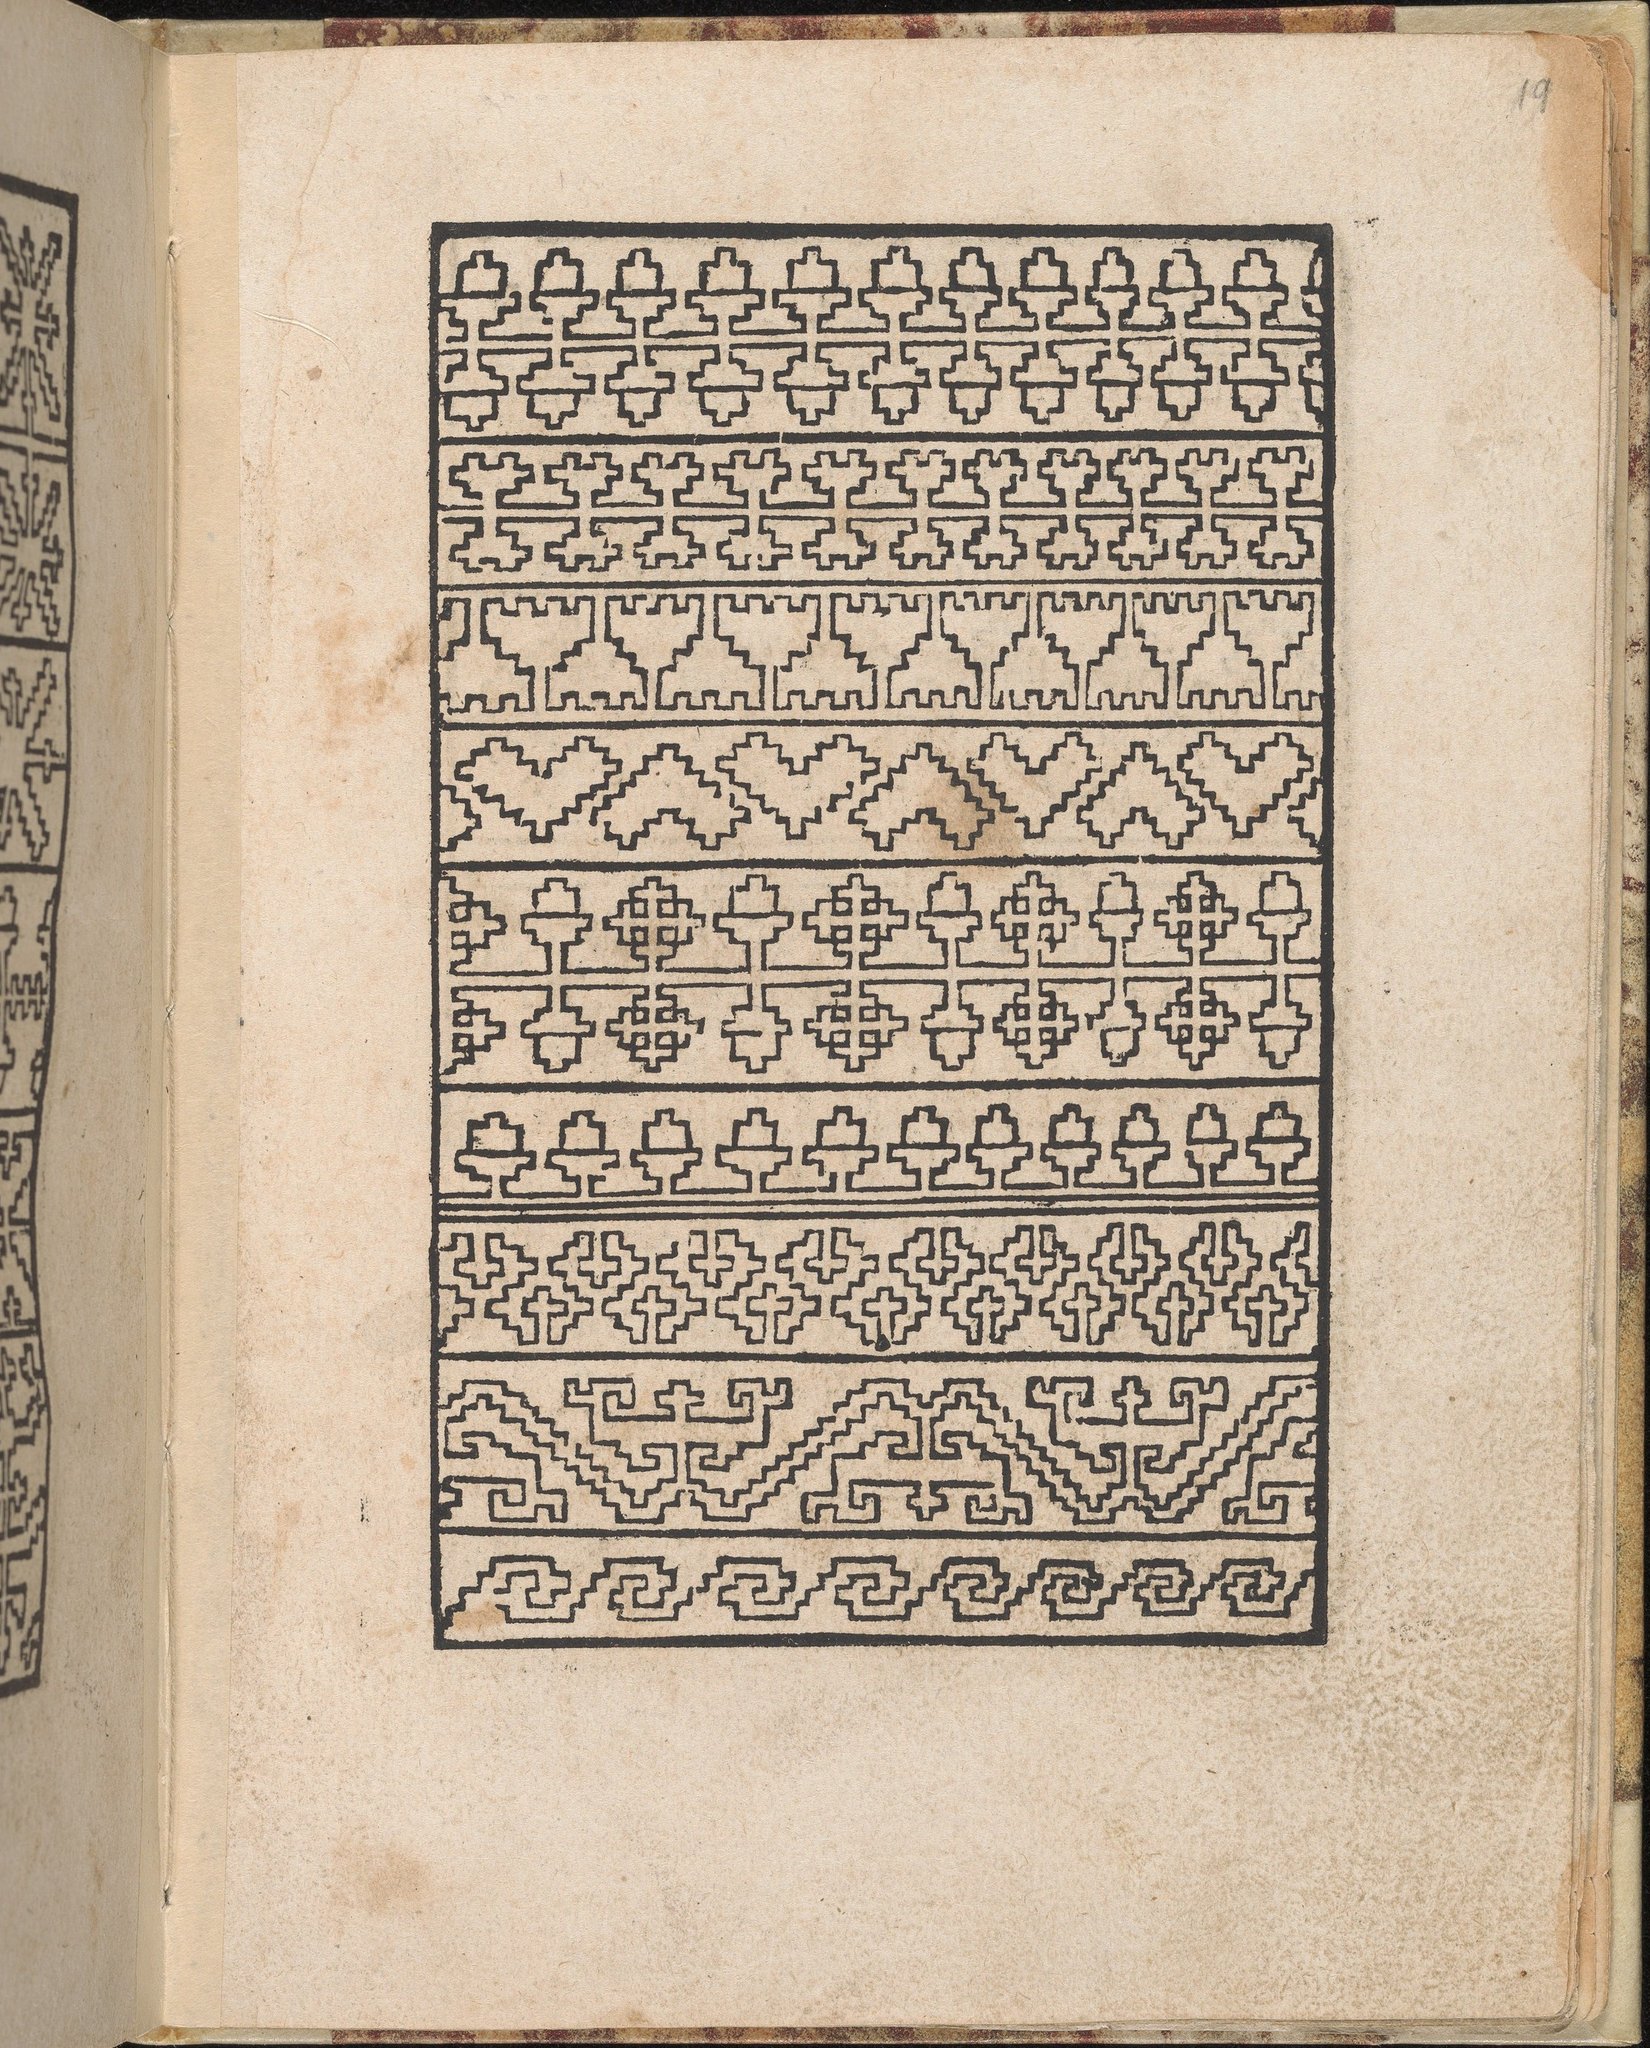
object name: book print ornament architecture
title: Ein new getruckt model Büchli...Page 18, verso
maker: johann schönsperger the younger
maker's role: publisher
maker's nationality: german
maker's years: 1490-1550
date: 1529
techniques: woodcut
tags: ornament